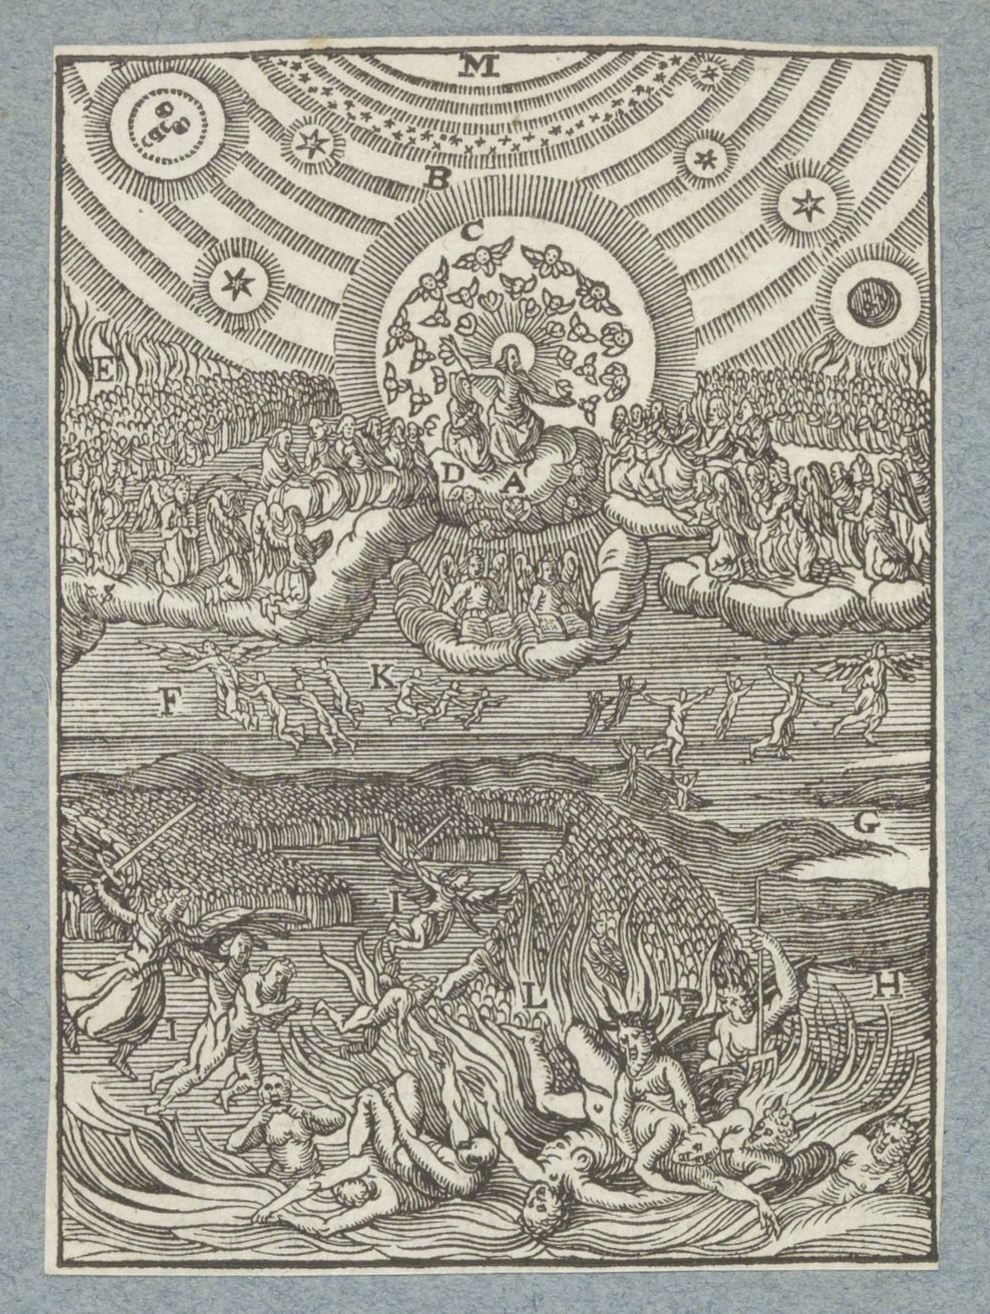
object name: print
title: Laatste Oordeel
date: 1629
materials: paper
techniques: letterpress printing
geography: amsterdam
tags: comprehensive representation of last judgement: christ (with sword and lily), often surrounded by elders and sometimes accompanied by mary and john the baptist, appears in the sky with trumpeting angels (and sometimes angels holding the instruments of the passion); after the resurrection of the dead the blessed are led to heaven by angels, and the damned are dragged into hell by devils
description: De prent is afkomstig uit een van de uitgaven van P.J. Paets uit Amsterdam. Ze wordt voor het eerst gebruikt in: Der Zielen Lust-hof. Leuven, I.Jacbosz voor P.J. Paets [= Amsterdam, P.J. Paets], 1629. De voorstelling is gekopieerd naar een prent van Johannes Wierix voor: Nadal, Jerónimo. Evangelicae Historiae Imagines. Antwerpen, M. Nutius, 1593.